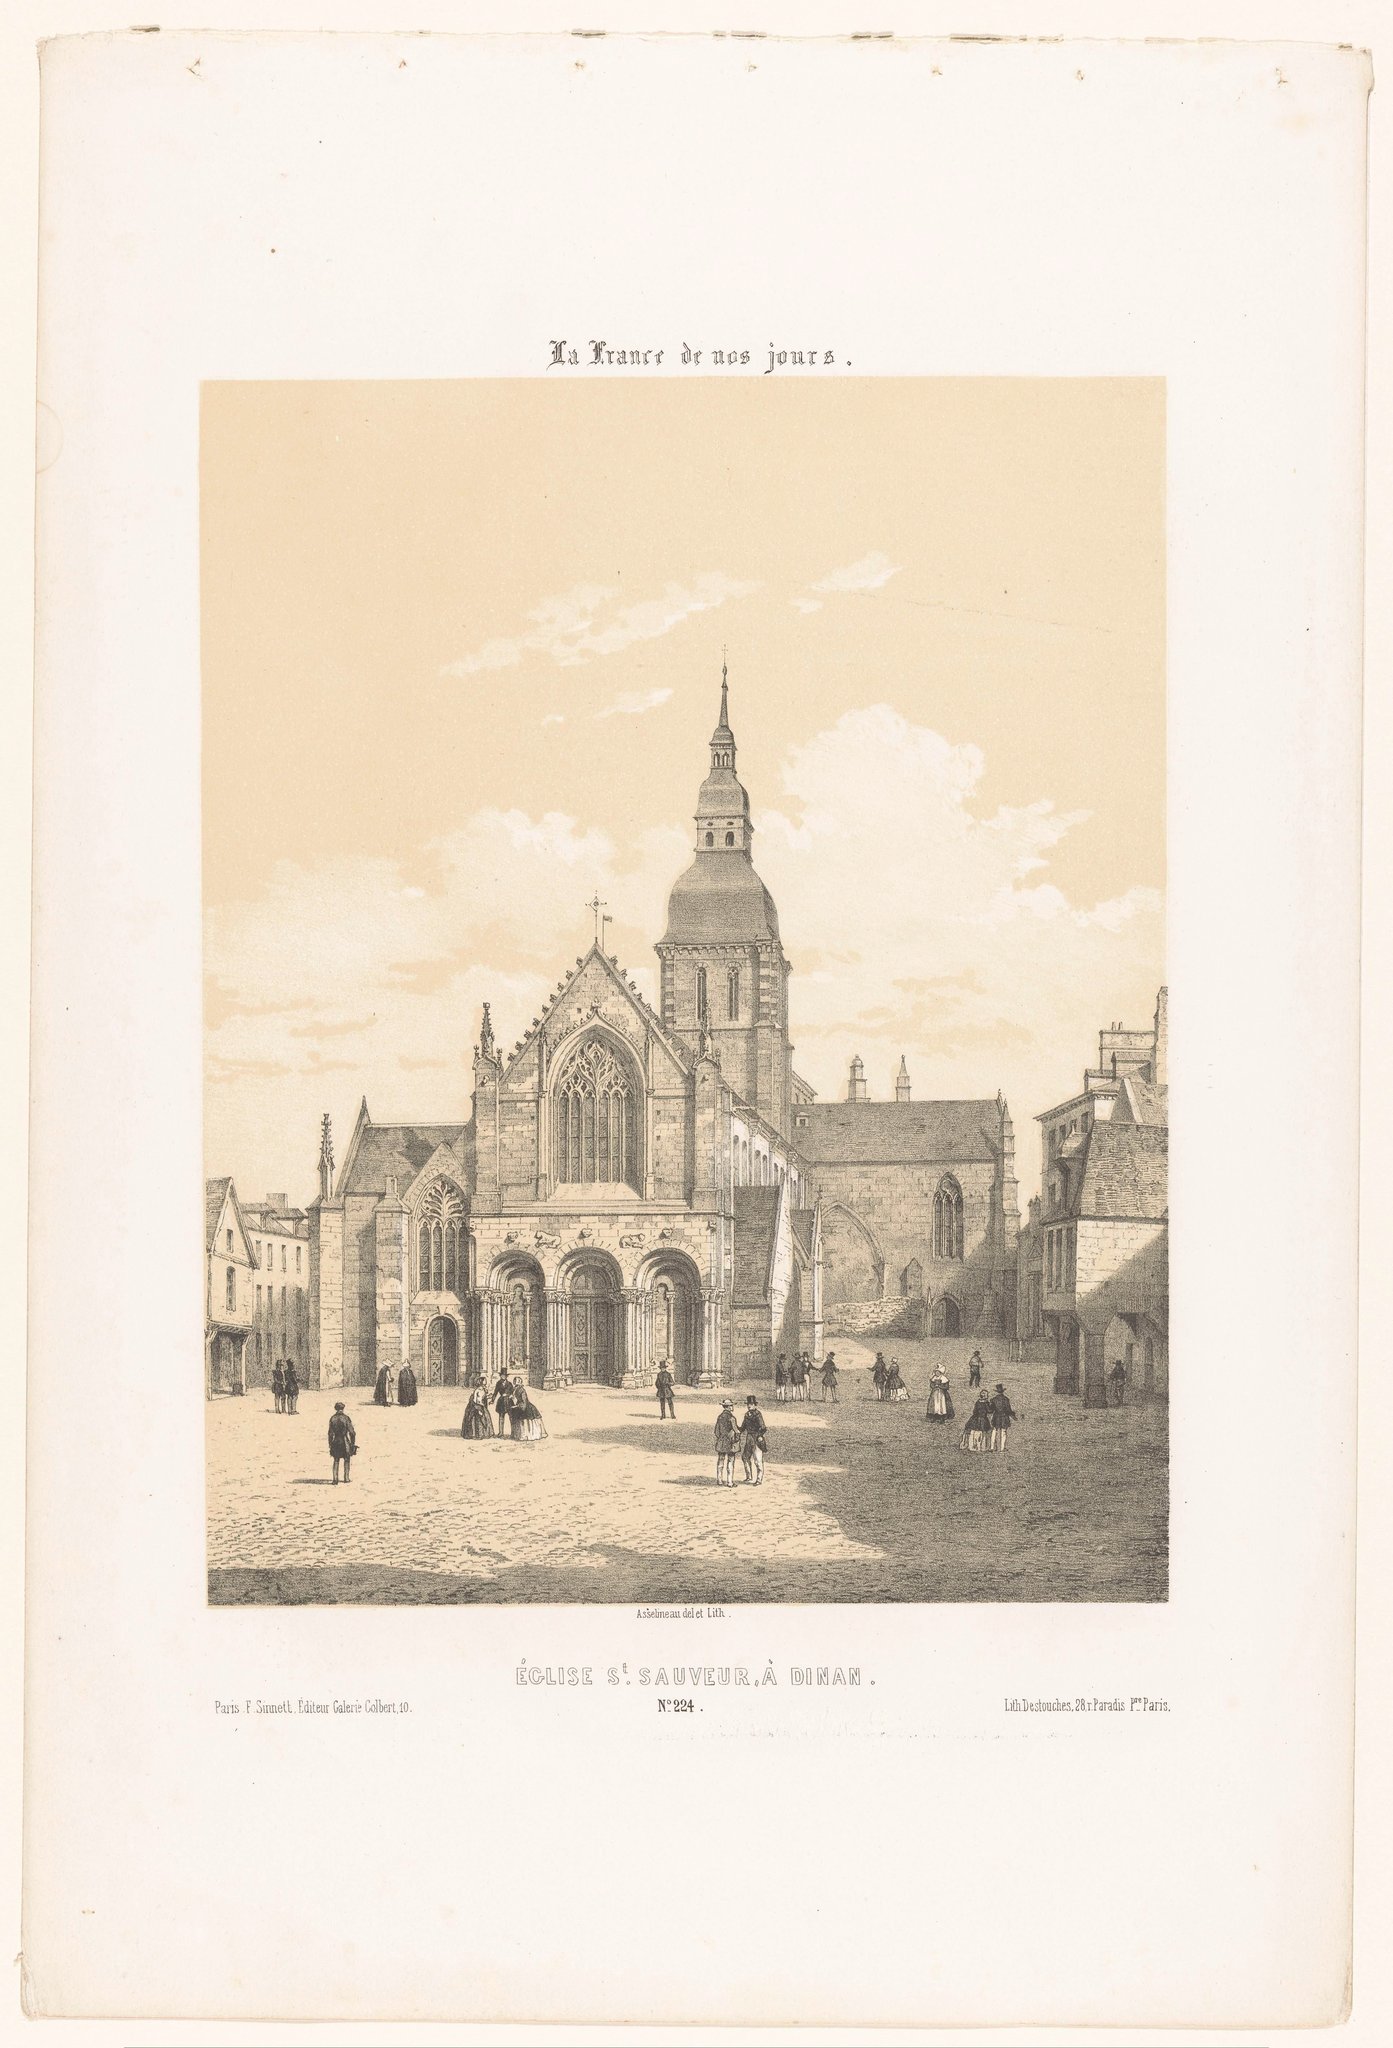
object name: print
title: Église St. Sauveur à Dinan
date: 1856-1858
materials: paper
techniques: tone lithography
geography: rouen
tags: church (exterior)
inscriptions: collector's mark: Lugt 2228